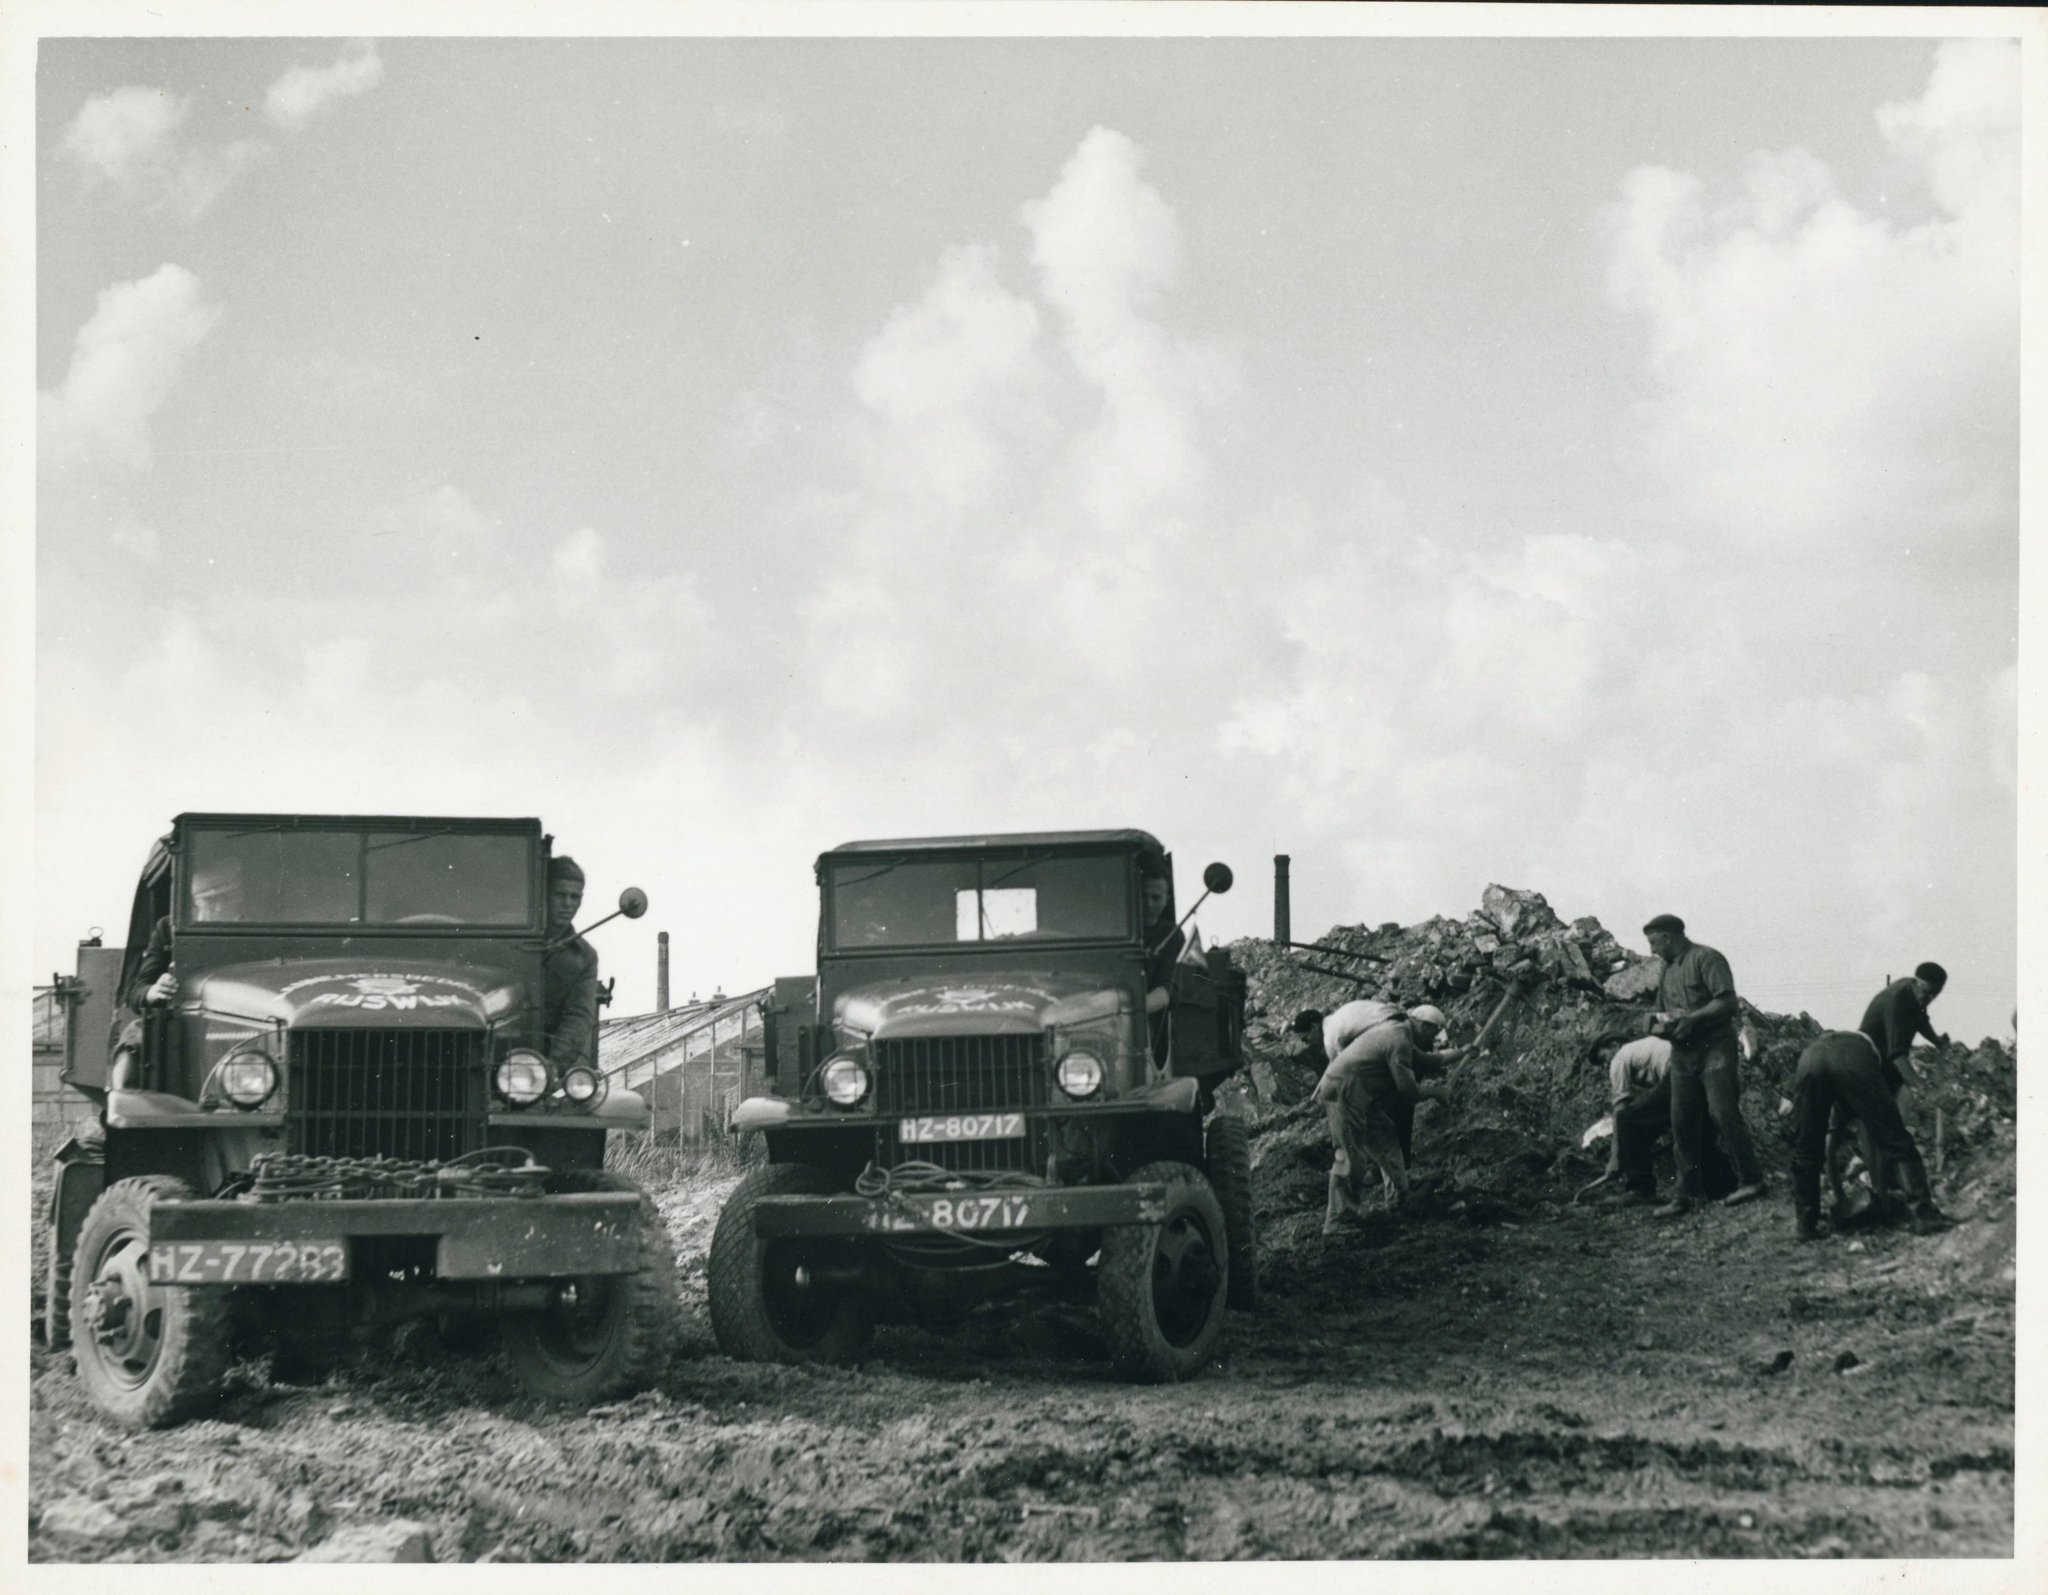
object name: documentary photograph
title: Amerikaanse vrachtauto's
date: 1946-1947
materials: photographic support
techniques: photography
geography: netherlands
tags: netherlands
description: Vrachtauto's uit Amerika worden gebruikt bij het afvoeren van puin, zodat hier nieuwe huizen gebouwd kunnen worden. Het beeld wordt voor het merendeel in beslag genomen door twee Amerikaanse vrachtwagens met daarnaast een grote bult puin in een drassig gebied waar een zestal arbeiders aan het werk zijn.